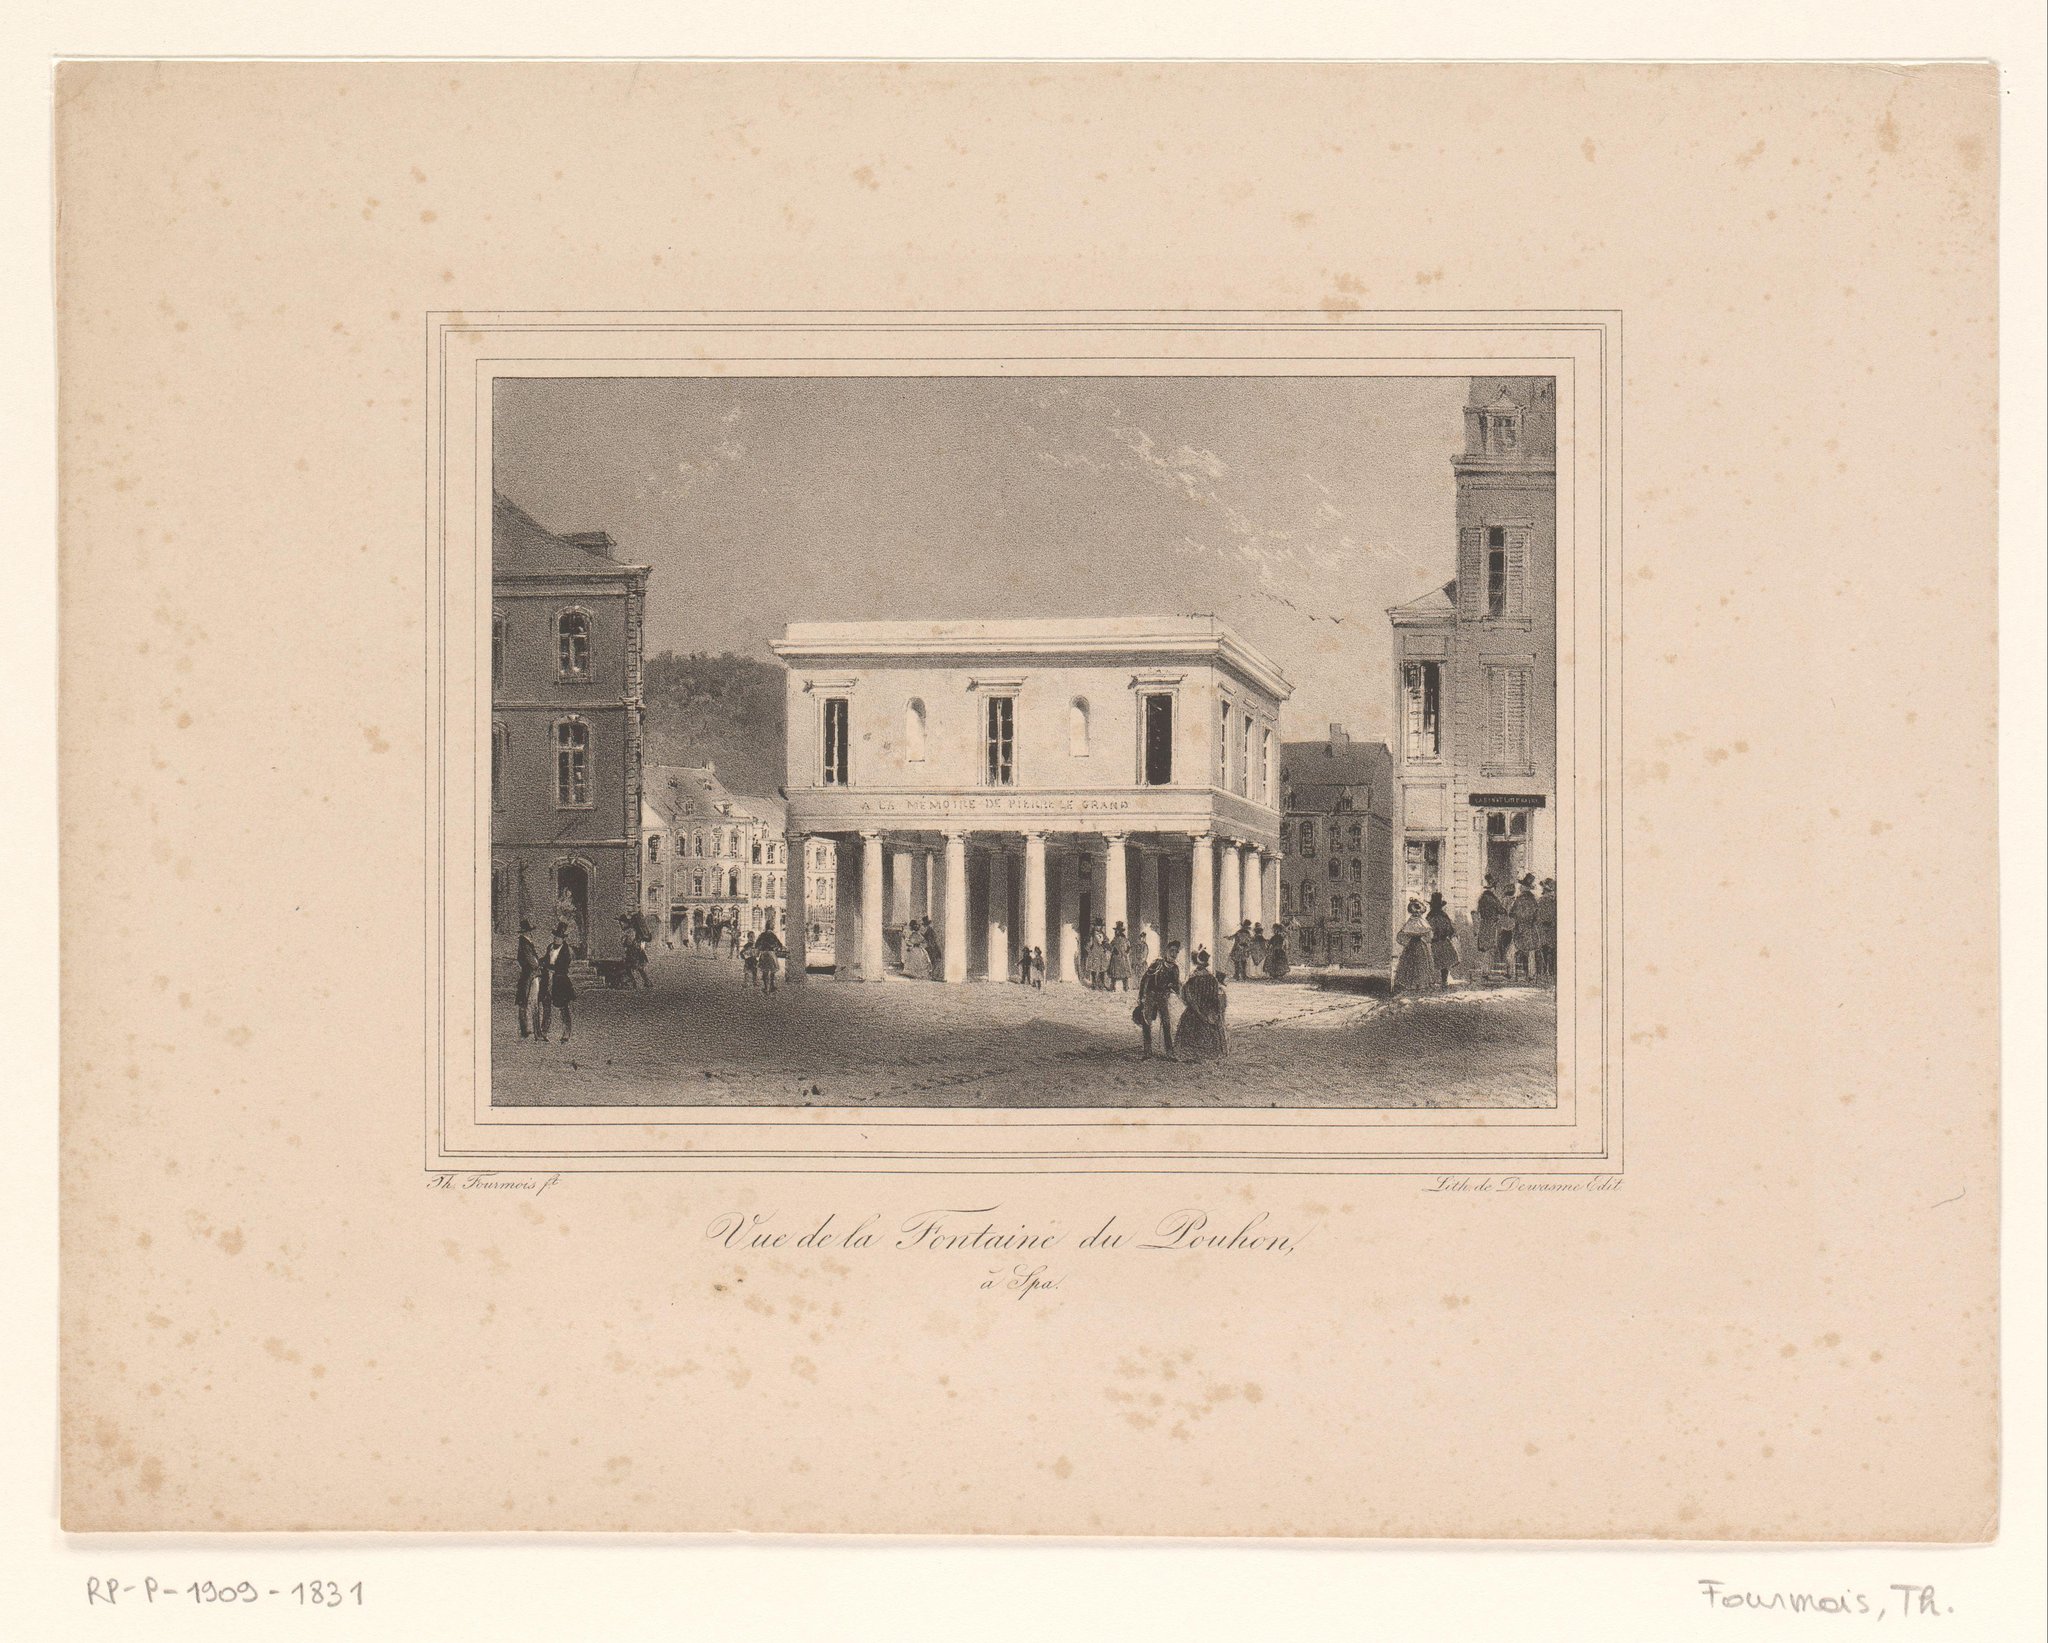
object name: print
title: Vues de Spa et de ses environs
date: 1833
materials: paper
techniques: lithograph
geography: brussels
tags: mineral water, civic architecture; edifices; dwellings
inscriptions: collector's mark: Lugt 2228